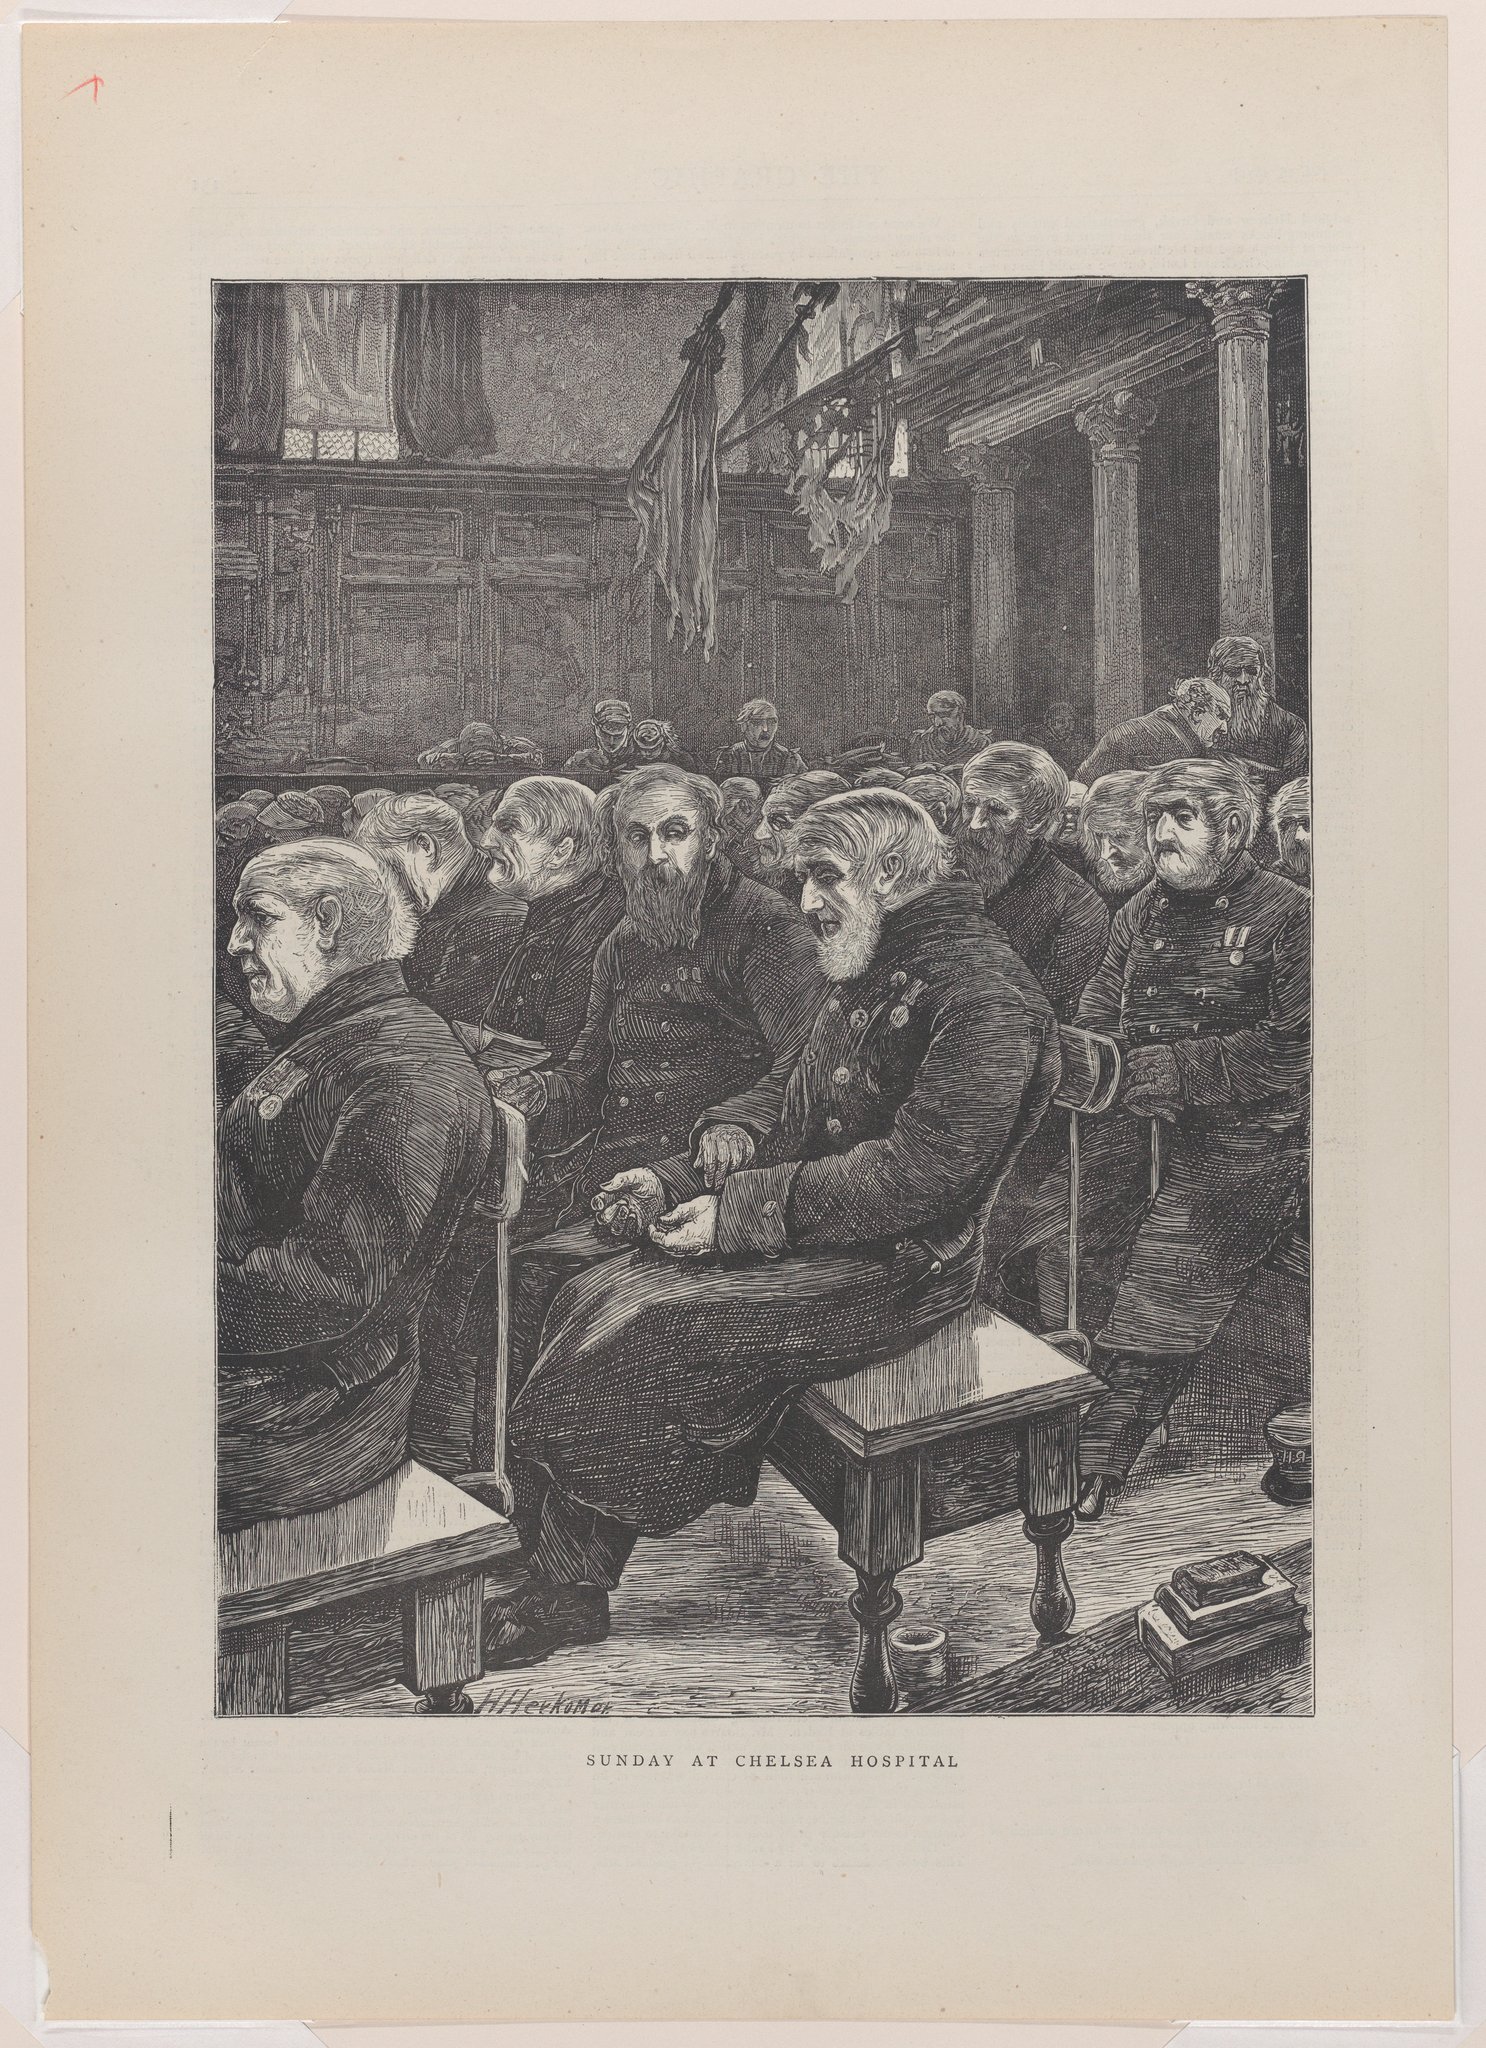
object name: print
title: Sunday at Chelsea Hospital, from "The Graphic," vol. 3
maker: sir hubert von herkomer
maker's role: artist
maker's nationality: british, born germany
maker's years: 1849-1914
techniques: engraving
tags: soldiers,men